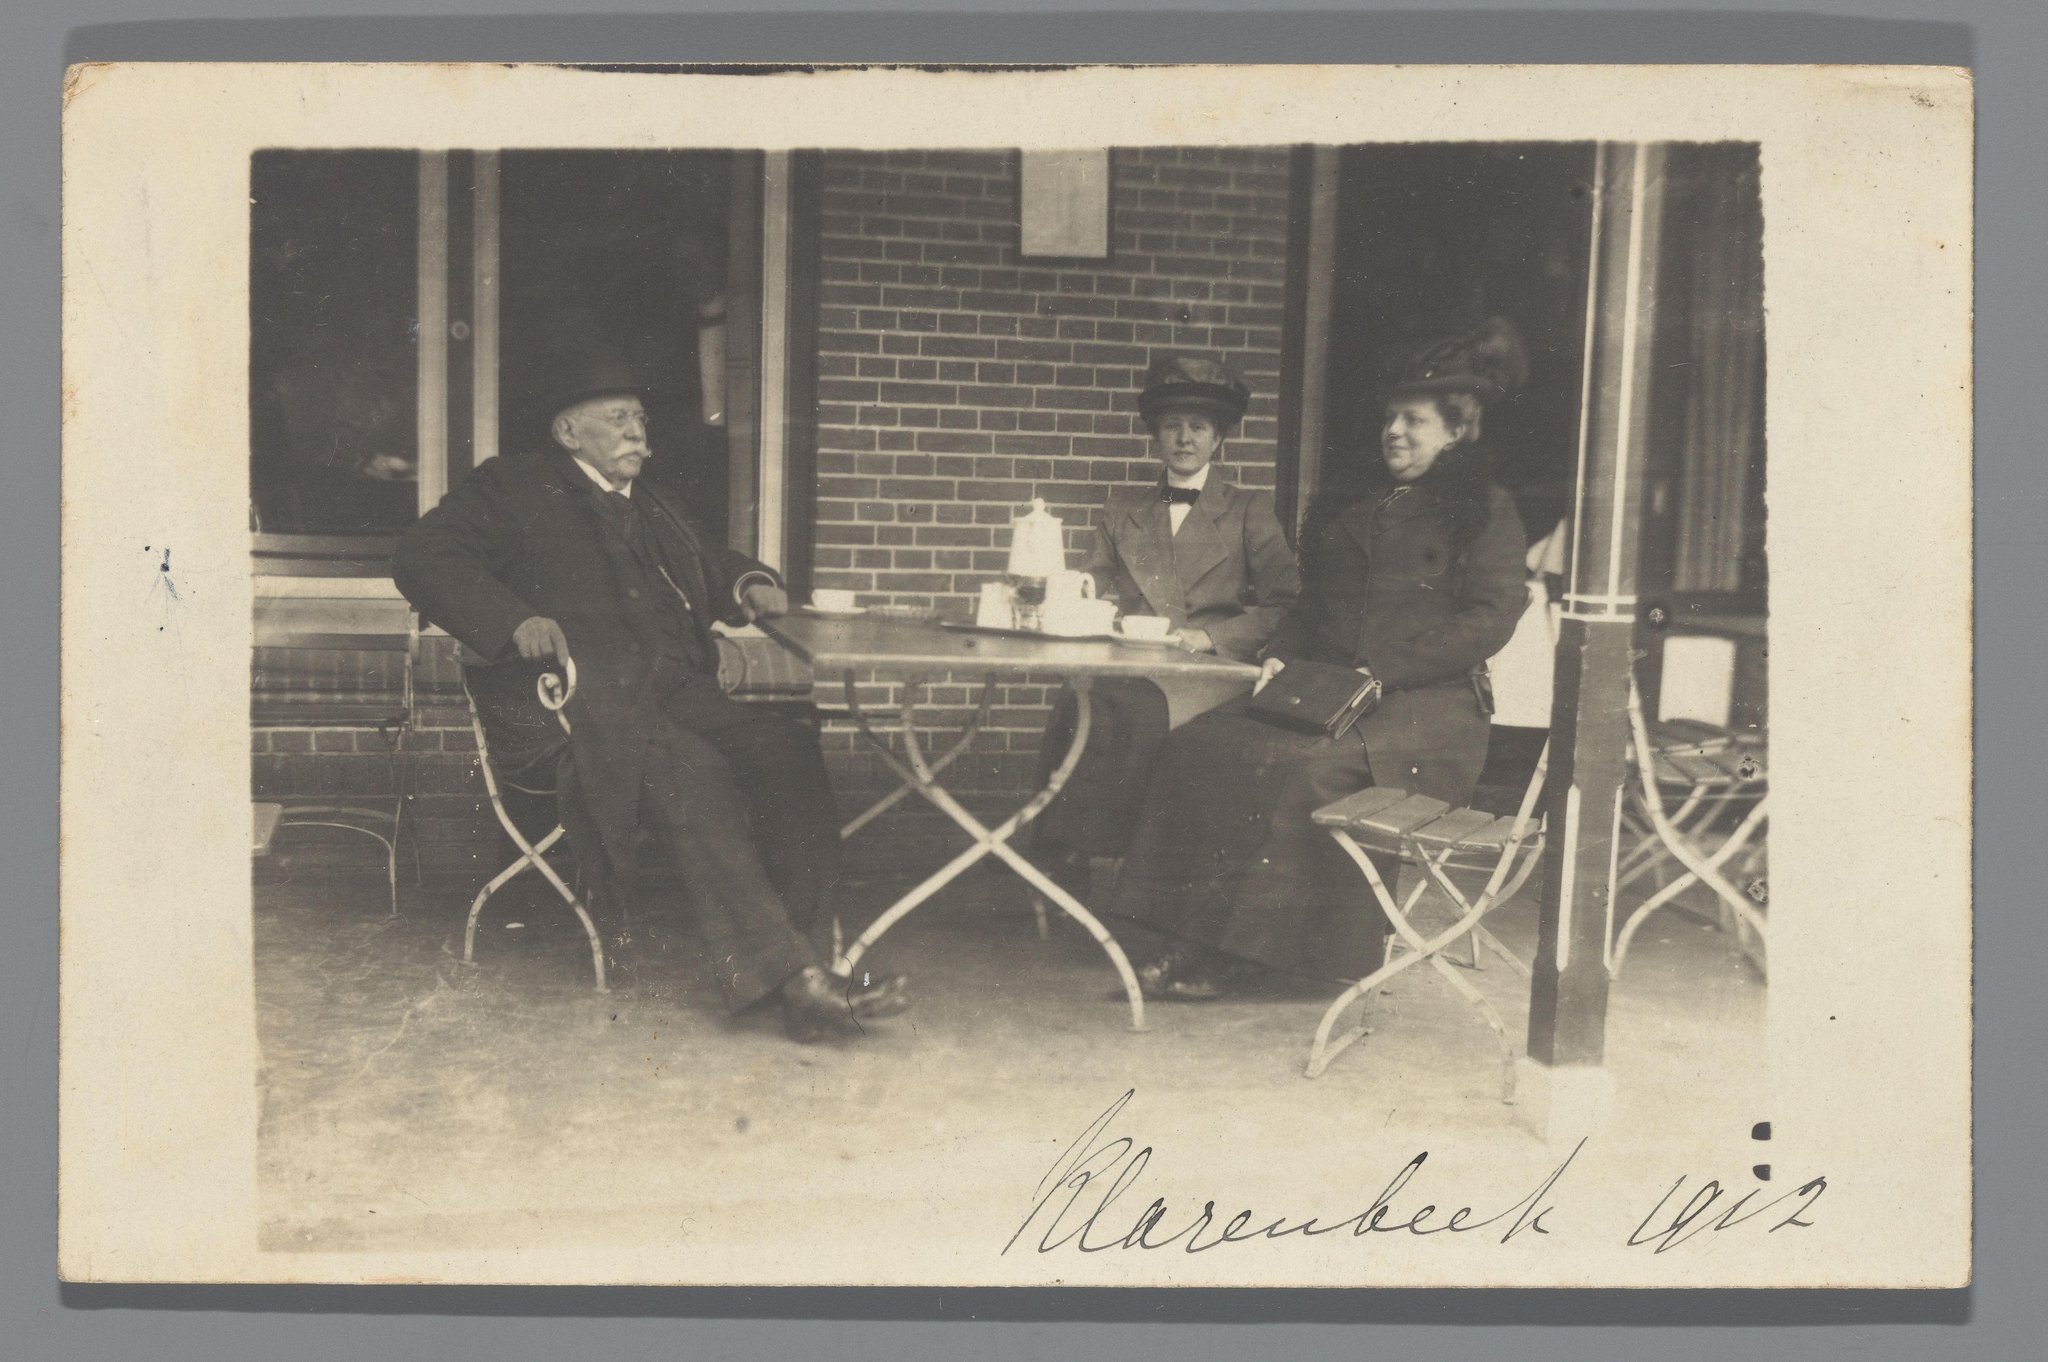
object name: photograph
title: Norbert van den Berg met twee vrouwen aan tafel op een terras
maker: Anonymous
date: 1912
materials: photographic support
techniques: albumen print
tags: rotterdam, amsterdam, norbertus petrus van den berg (1831-1917)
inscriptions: inscription: ‘Klarenbeek 1912’